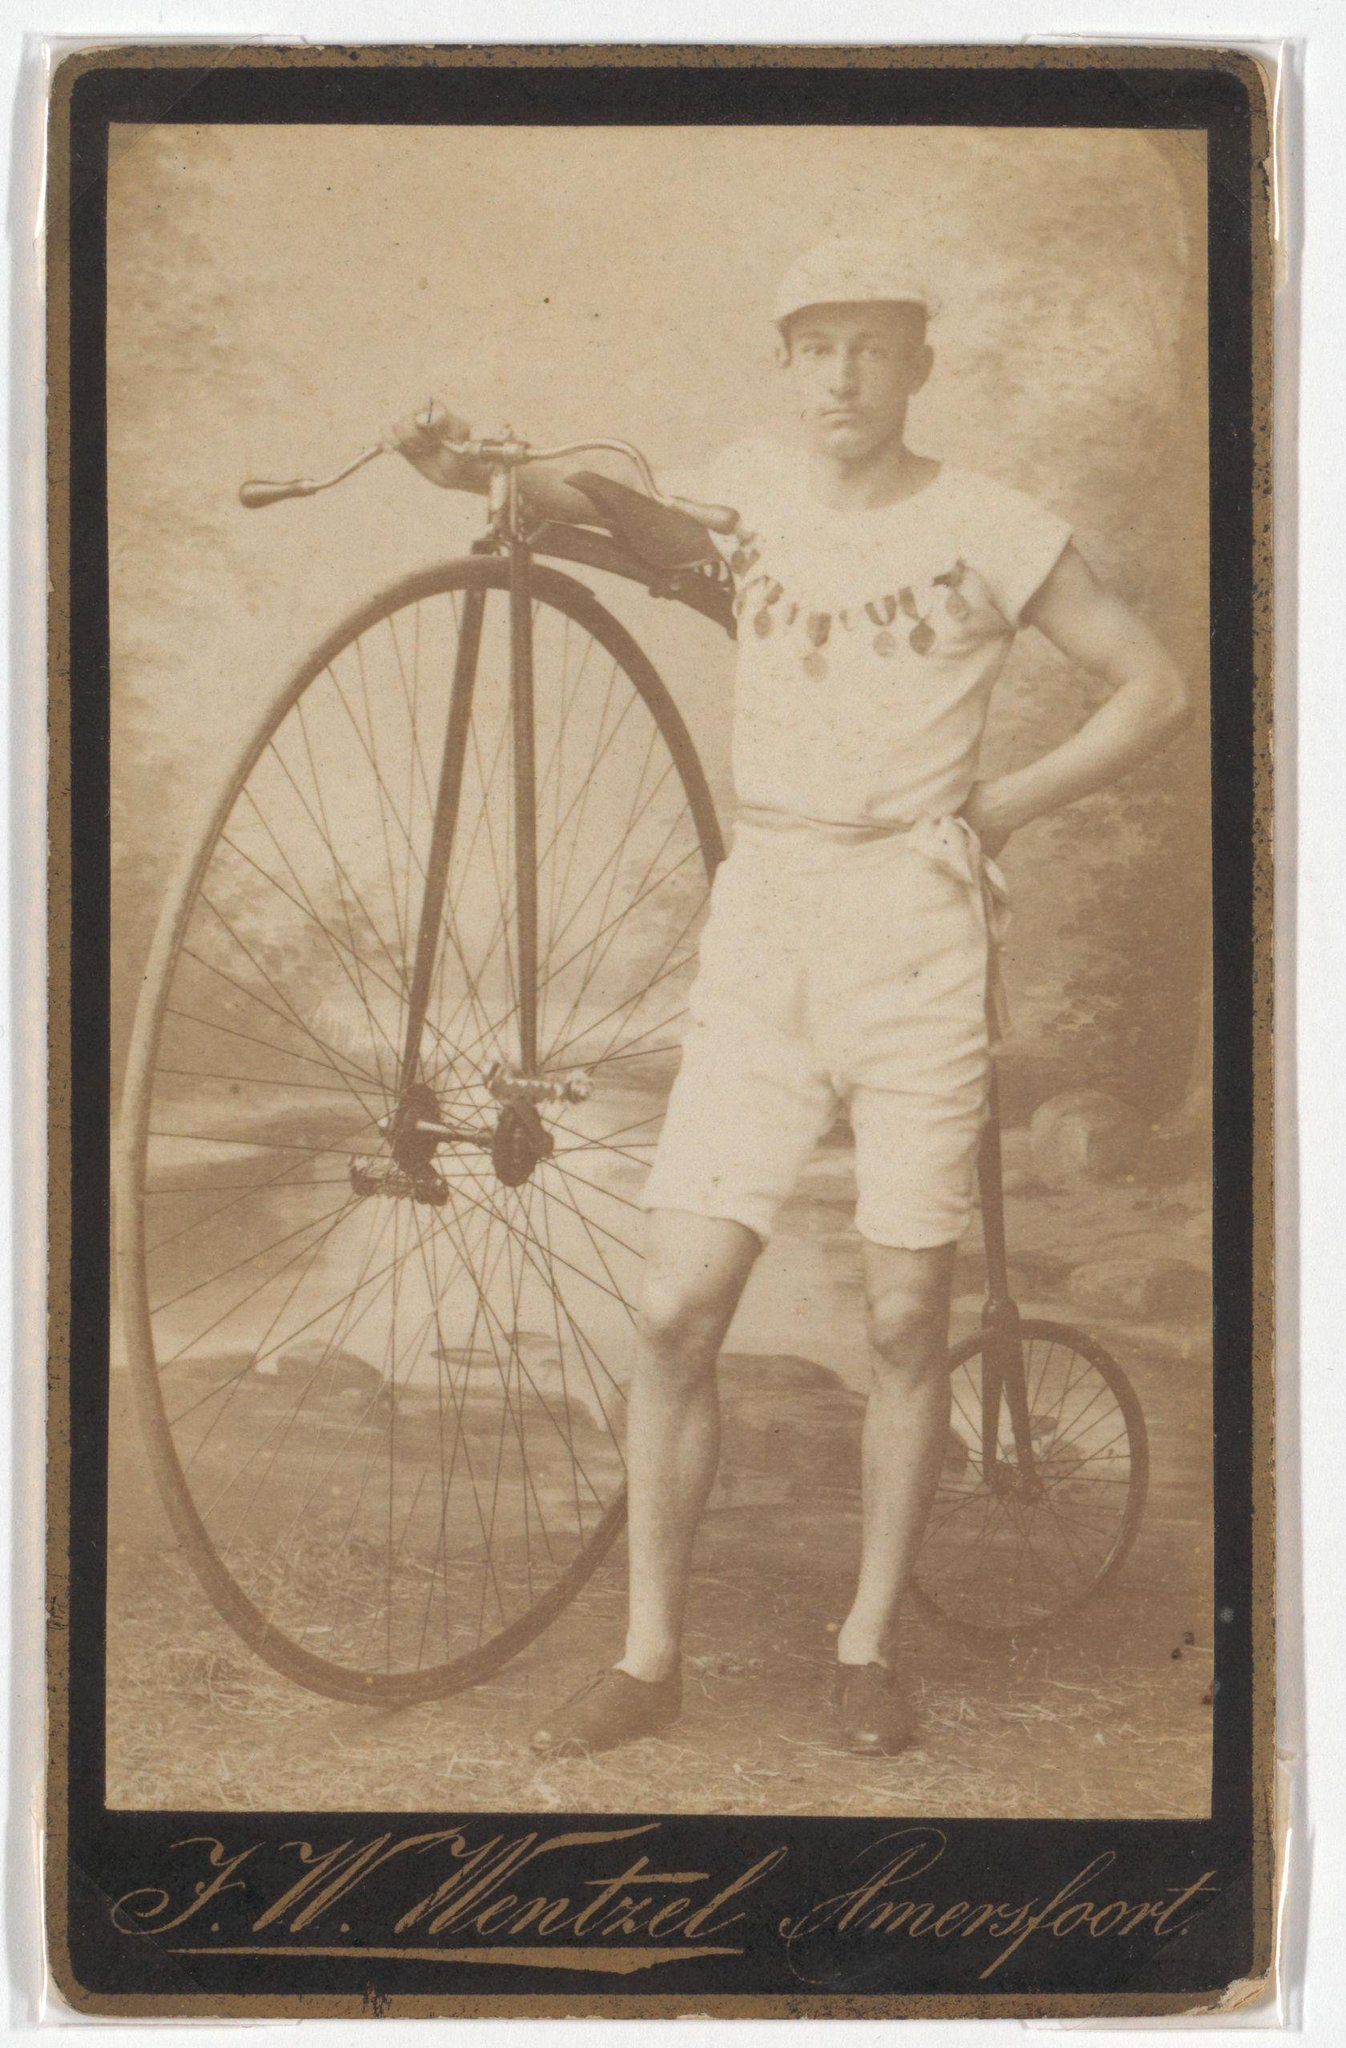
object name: carte de visite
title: Portret van een met medailles behangen sportman bij een hoge bi (vélocipède)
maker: j.w. wentzel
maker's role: fotograaf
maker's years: 1855-1930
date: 1883-1890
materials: cardboard, paper, photographic support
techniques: albumen print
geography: amersfoort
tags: studio requisites ~ photographer, bicycle racing (+ sportsman, player, etc.), bicycle, historical persons not known by name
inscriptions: address: ‘Langegracht F. 200 Amersfoort’